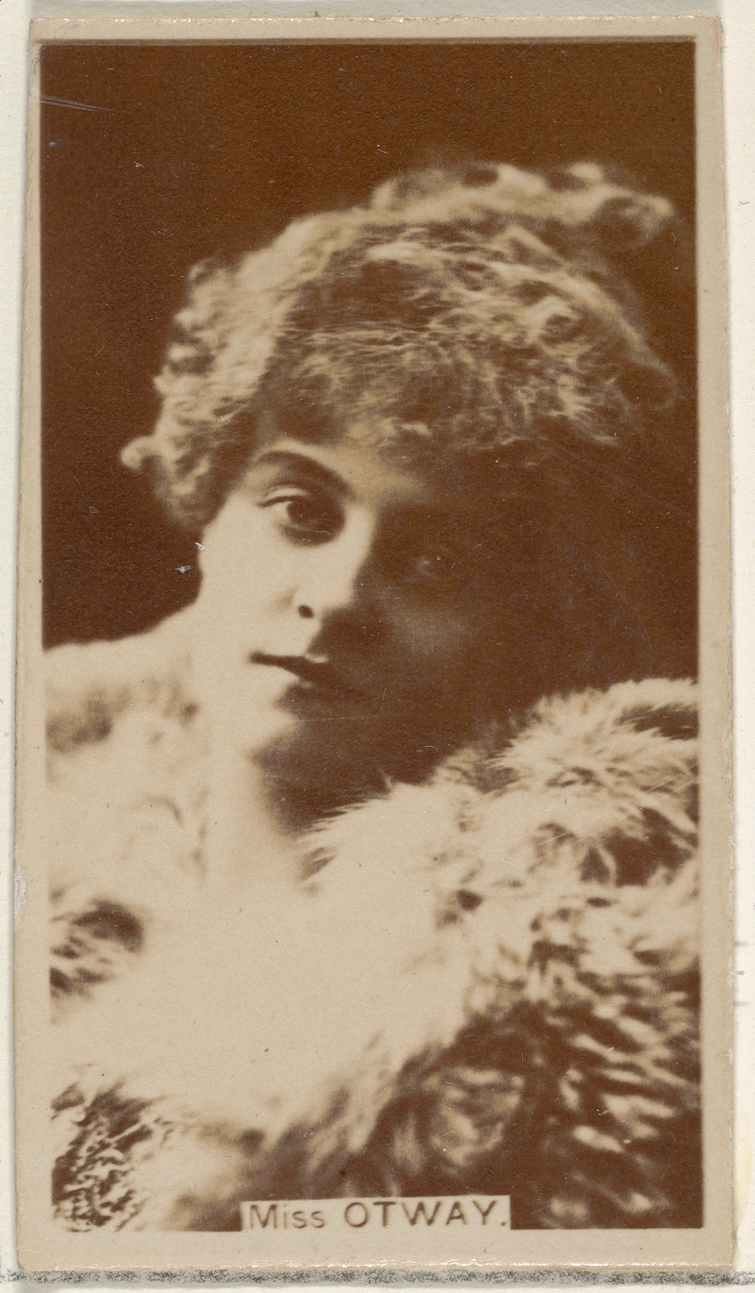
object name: photograph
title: Miss Otway, from the Actors and Actresses series (N45, Type 8) for Virginia Brights Cigarettes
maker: allen & ginter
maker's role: publisher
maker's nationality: american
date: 1888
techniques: albumen silver print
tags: portraits,women,actresses